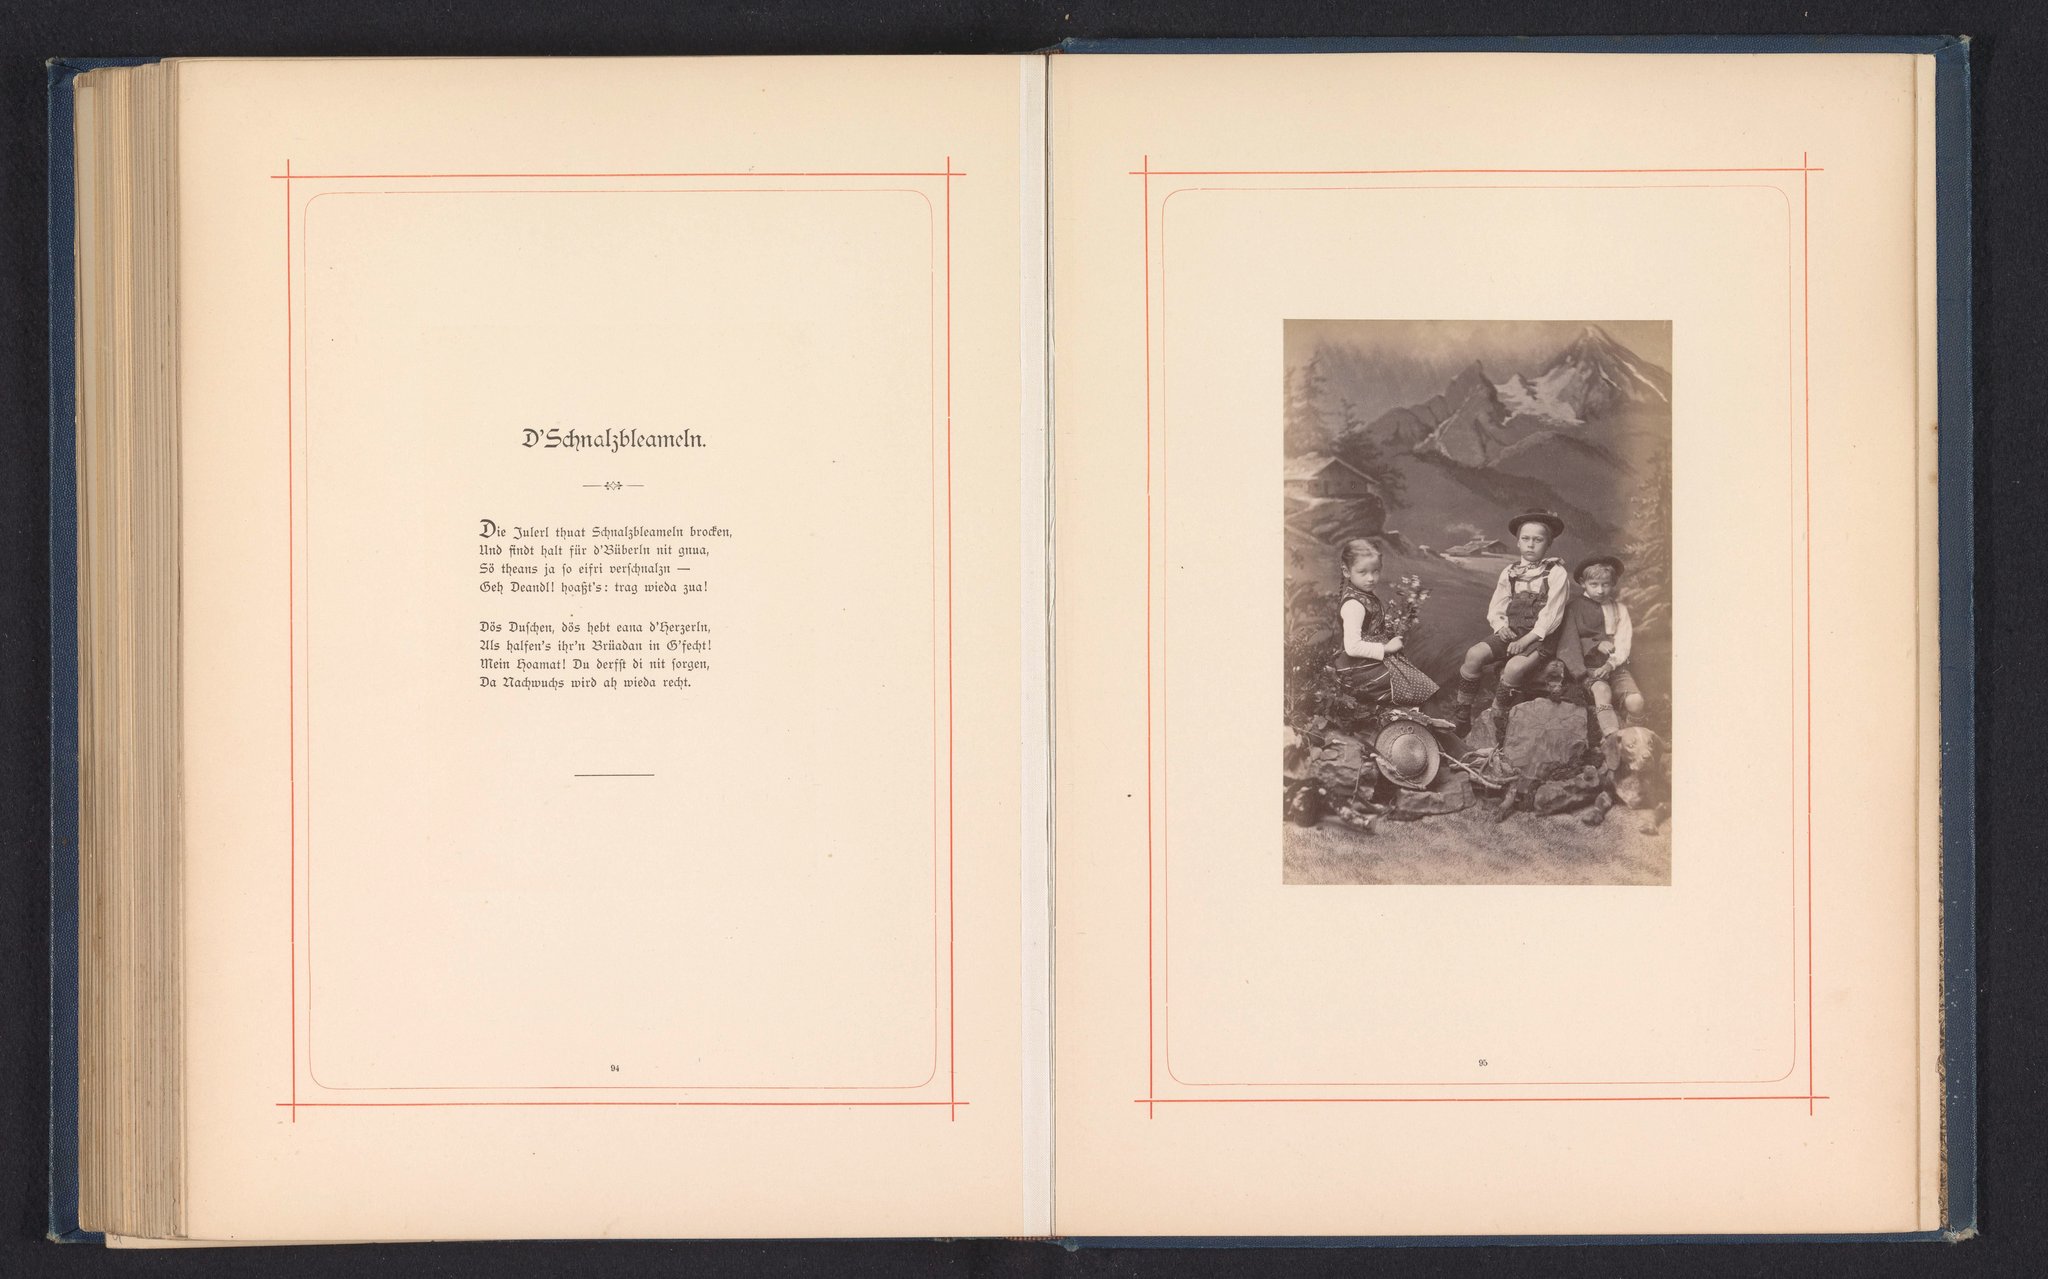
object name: page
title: Drie kinderen in klederdracht voor een berglandschap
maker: max balde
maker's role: fotograaf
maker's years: 1844-1900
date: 1877-1882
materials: photographic support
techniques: albumen print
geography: salzburg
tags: child, folk costume, regional costume